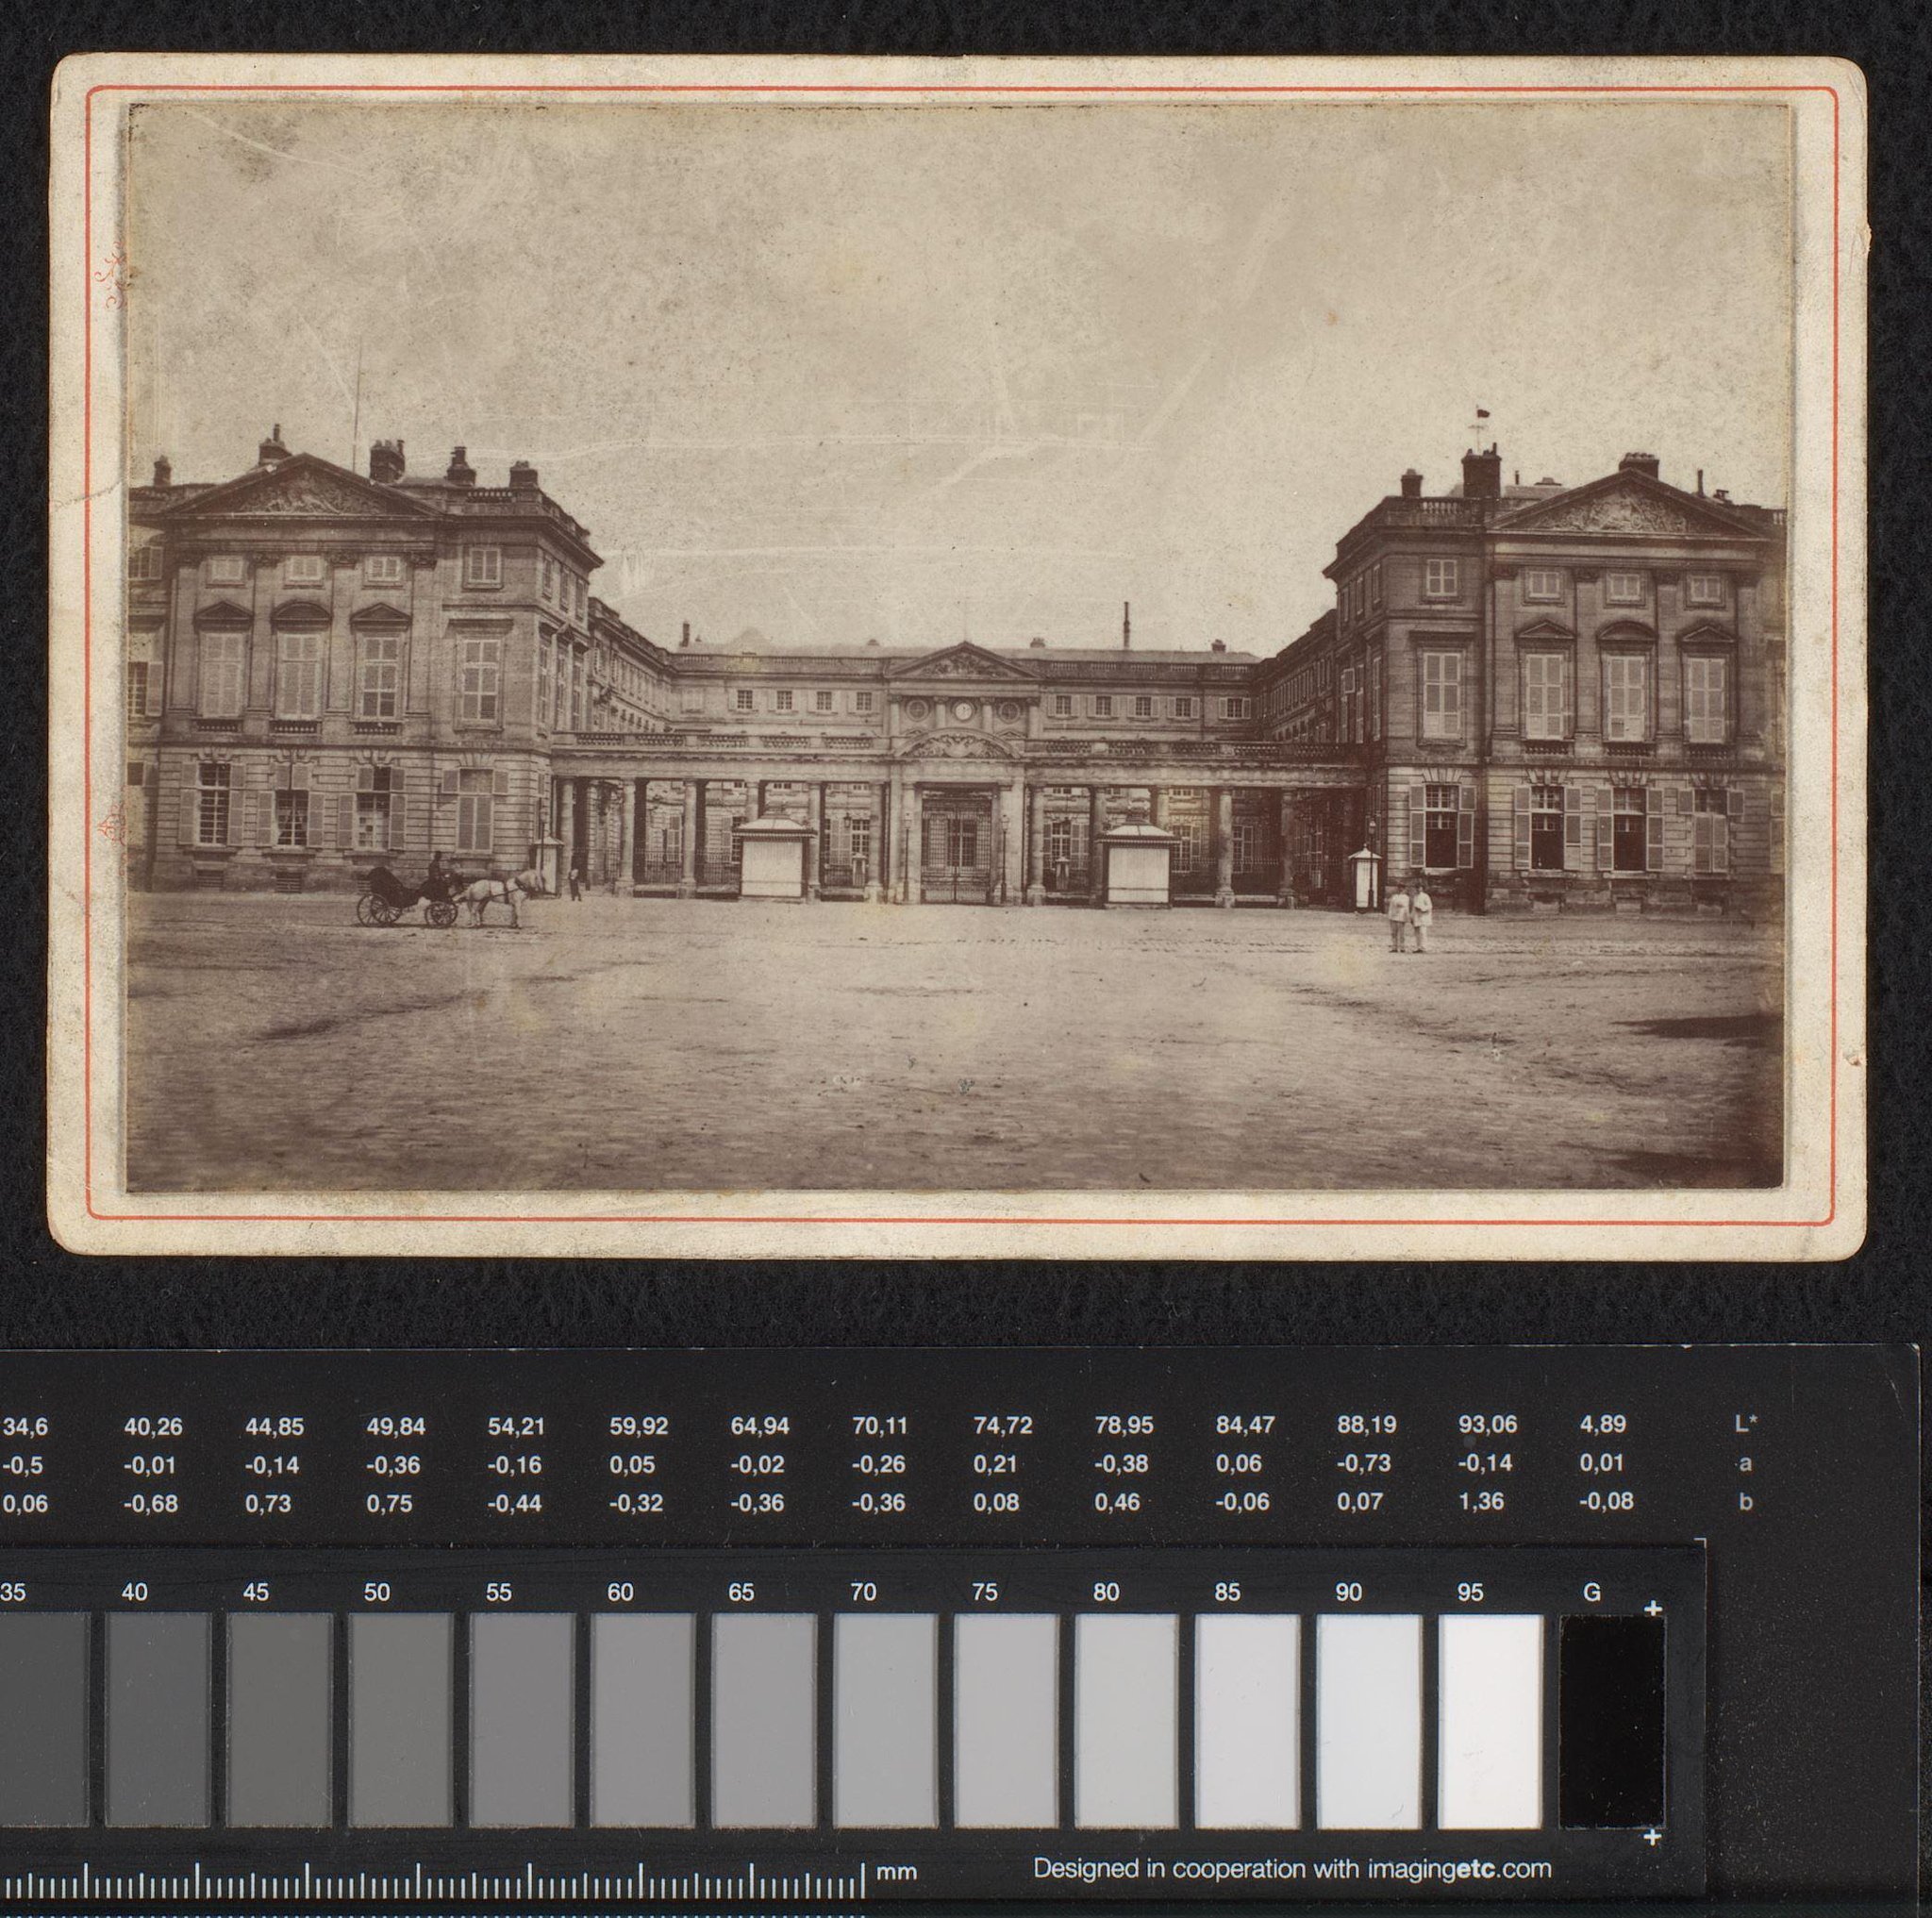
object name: cabinet photograph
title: Château de Compiègne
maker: a. dupré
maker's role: fotograaf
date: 1880-1900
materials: paper, cardboard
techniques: collodion silver print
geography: compiègne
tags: palace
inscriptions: inscription: ‘A. Dupré/ Photographe/ AD/ Rue Solferino, 39./ Compiègne’